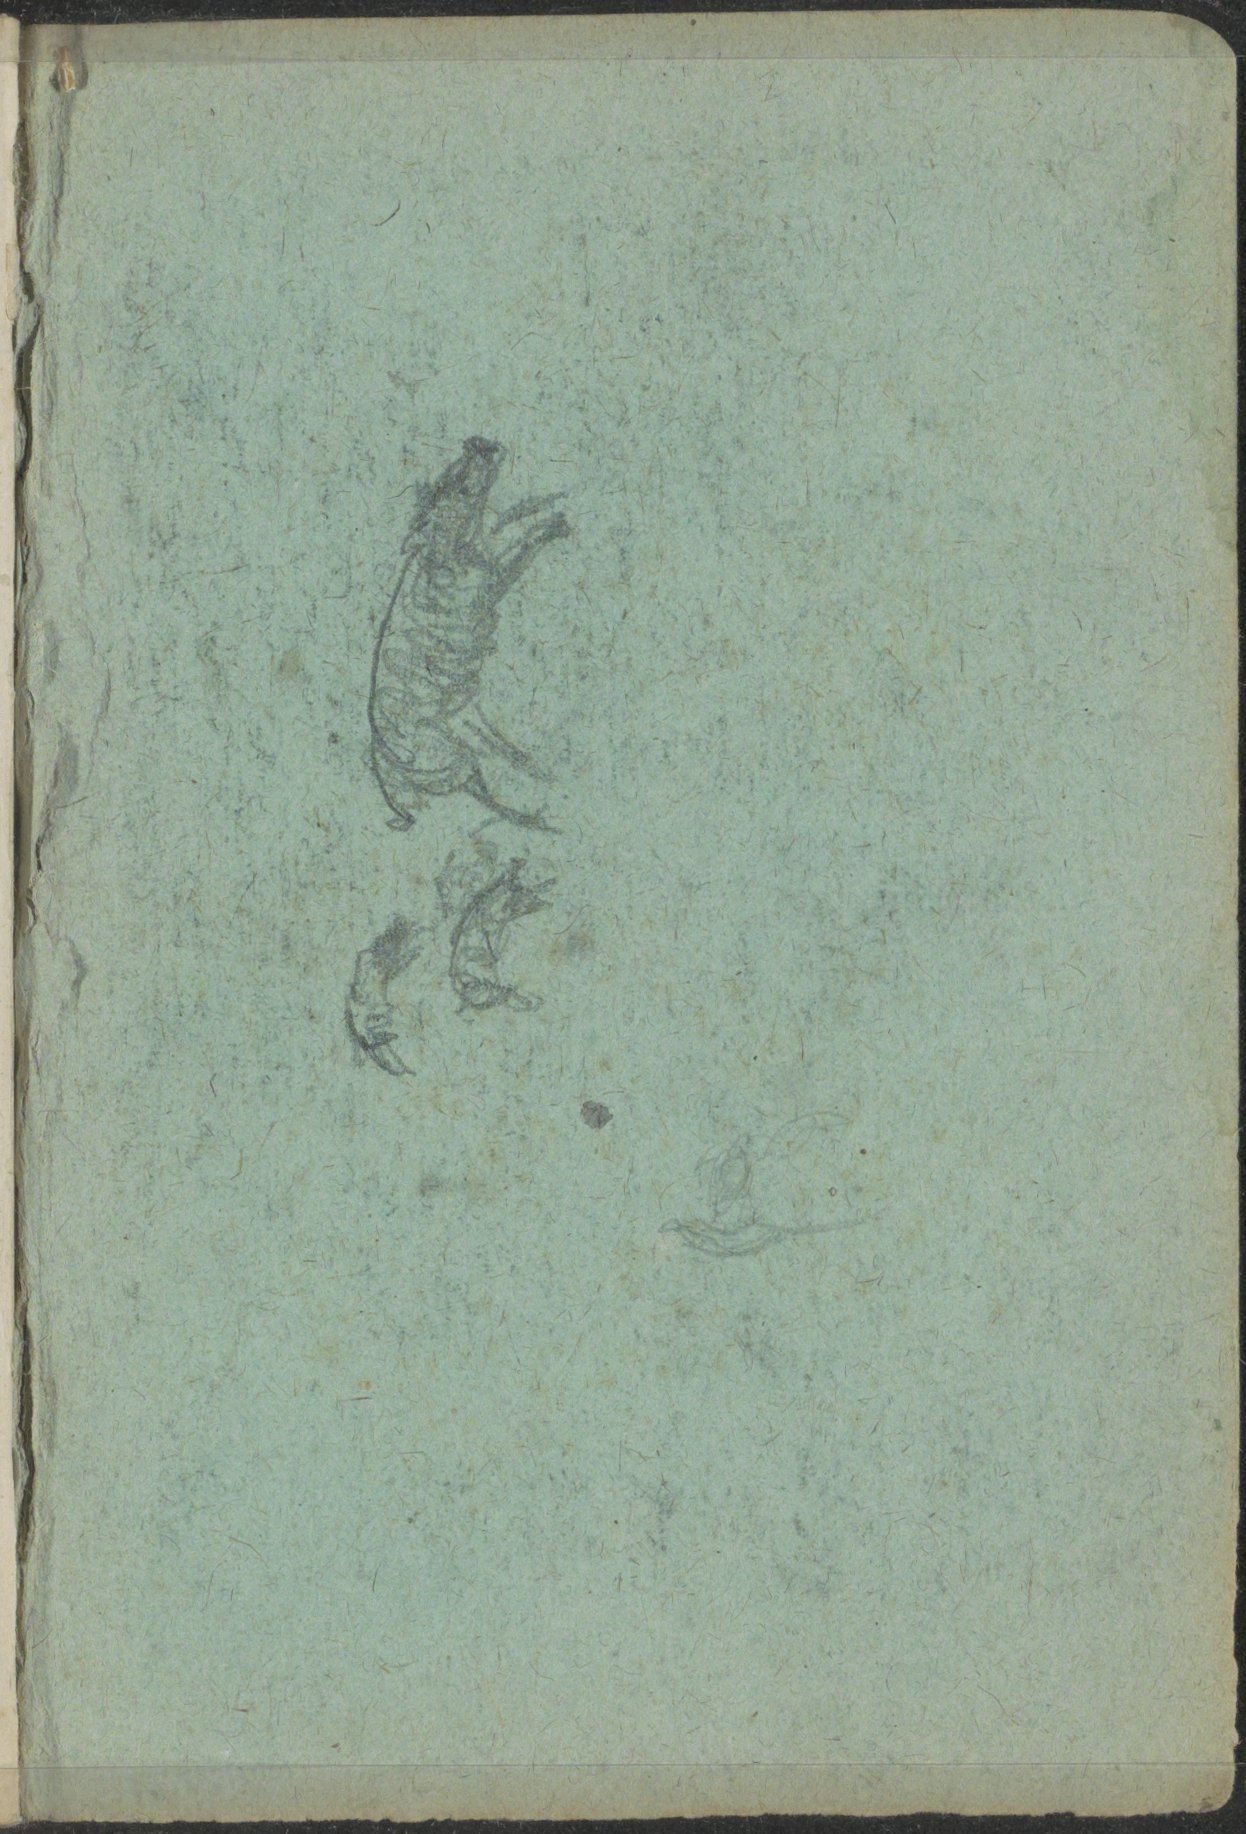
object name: endleaf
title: Zwijnen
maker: marius bauer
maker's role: draughtsman, print maker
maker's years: 1867-1932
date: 1902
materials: paper, pencil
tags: pig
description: Achterste schutblad uit een schetsboek met 50 bladen.